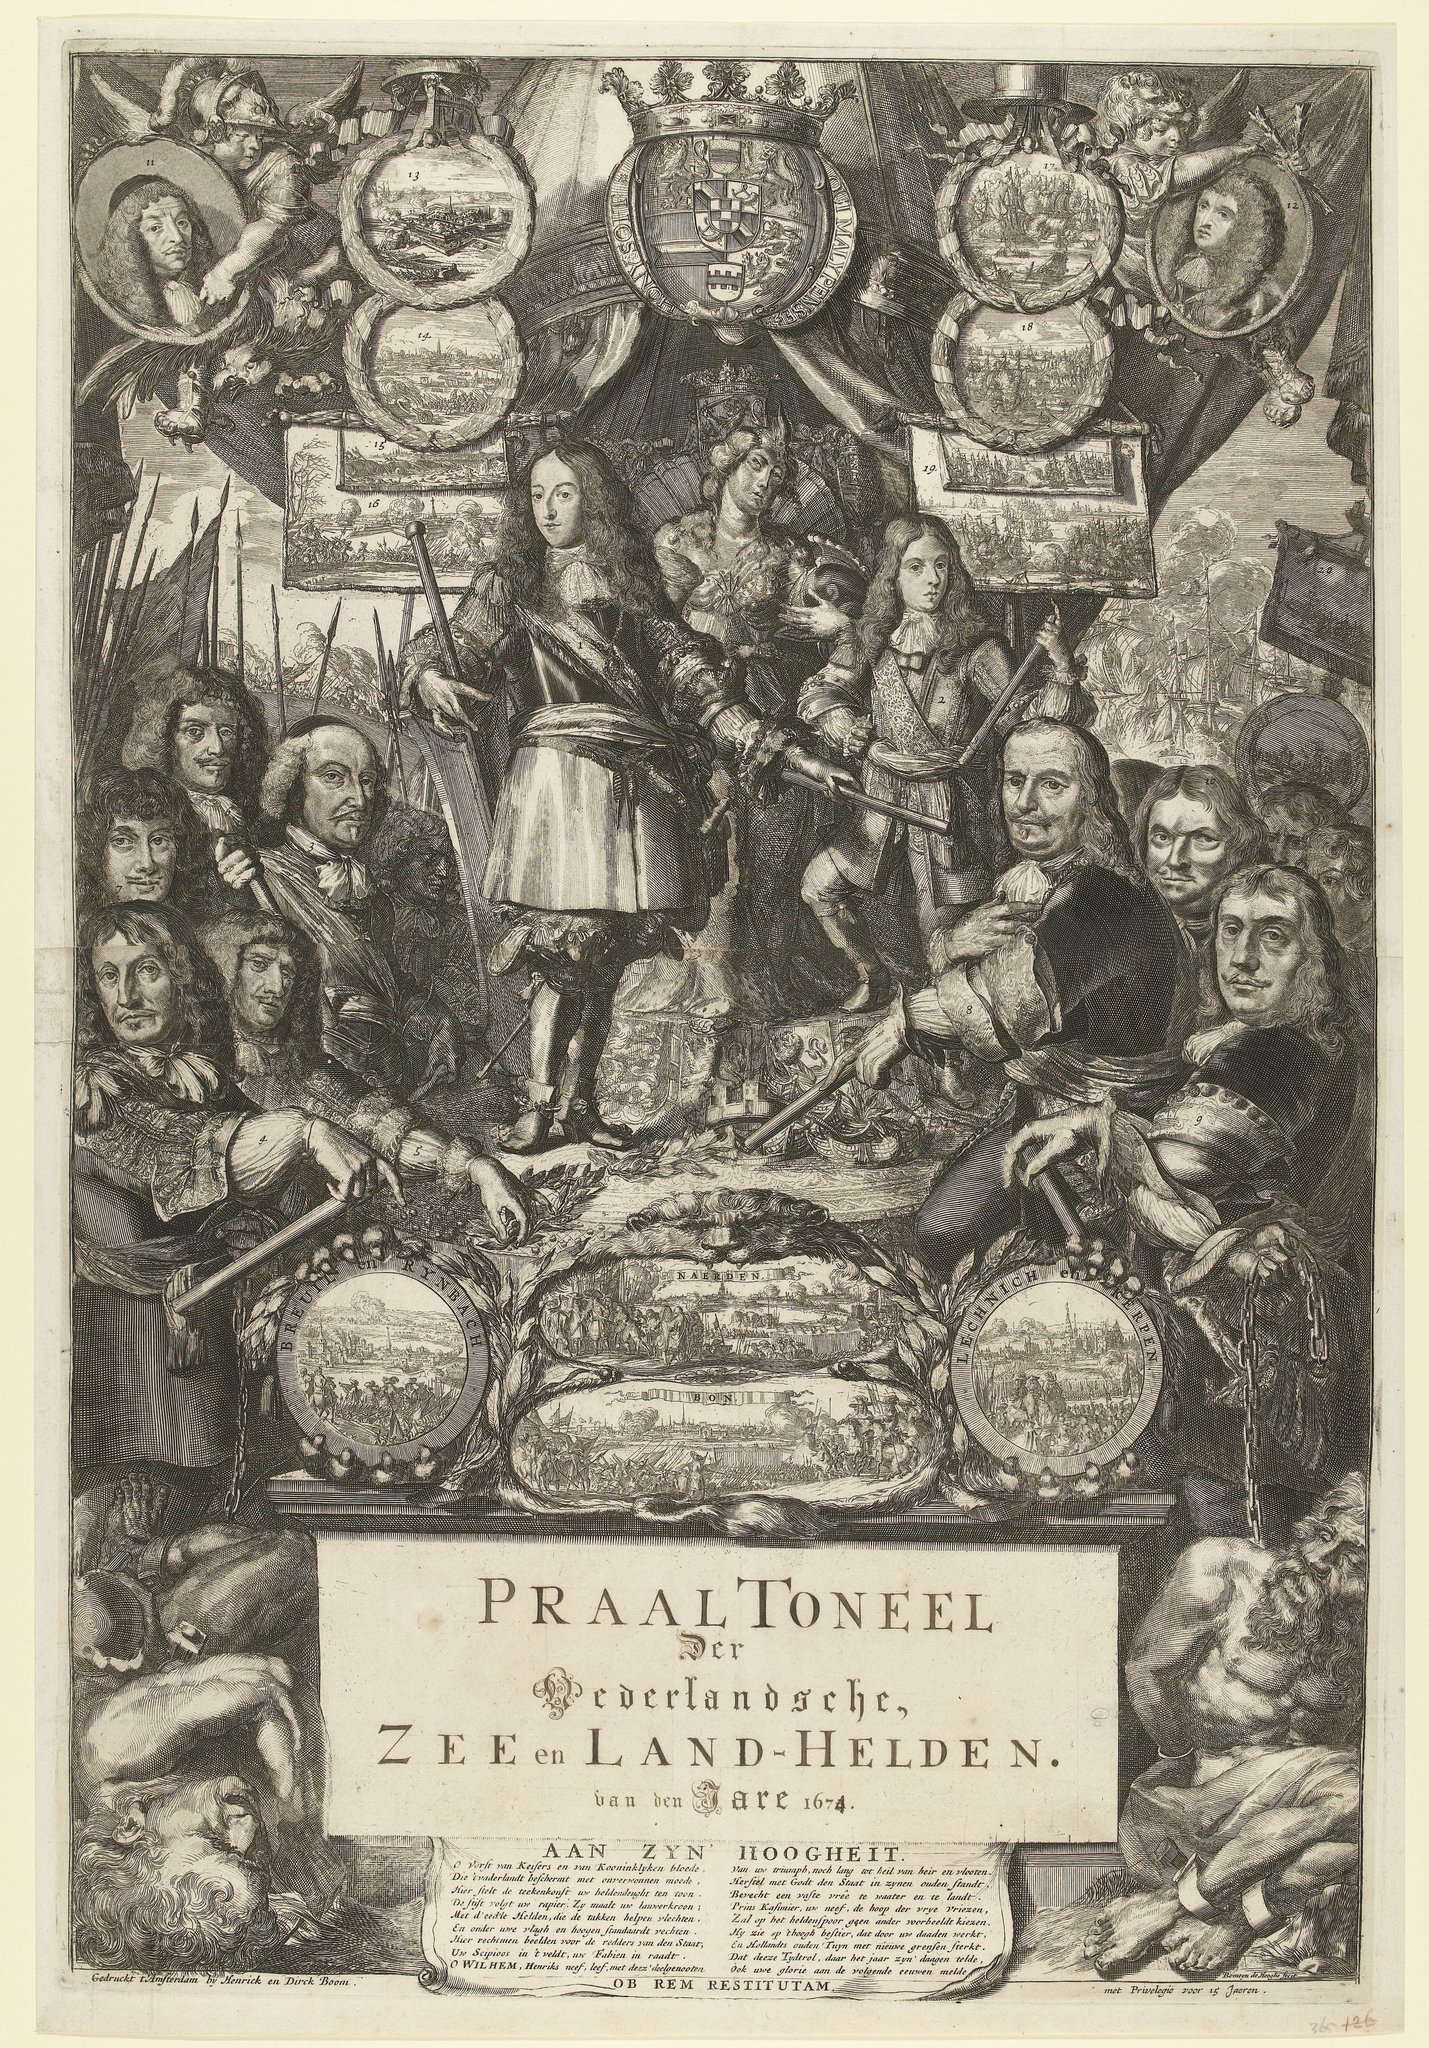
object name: propagandaprent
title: Allegorie op de overwinningen van Willem III in 1673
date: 1673-1674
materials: ink, paper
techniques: engraving, etching, pen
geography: northern netherlands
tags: flushing, michiel adriaenszoon de ruyter, rotterdam, amsterdam, cornelis tromp, johan maurits graaf van nassau-siegen, the hague, william iii (prince of orange and king of england, scotland, and ireland), juan domingo méndez de haro y fernández de córdoba, hendrik casimir ii graaf van nassau-dietz, commander-in-chief, general, marshal, prince, military glory, commander-in-chief, admiral, rampjaar (disaster year)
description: Allegorie op de overwinningen van Willem III in 1673. De jonge prins met commandostaf staande naast de jonge Hendrik Casimir. Hiervoor bevelhebbers die in 1673 overwinningen behaalden: Michiel Adriaenszoon de Ruyter, Cornelis Tromp, Adriaen Banckert, Johan Maurits, Paulus Wirtz, George Frederik van Waldeck, Rabenhaupt en graaf Willem van Hornes. Hieromheen medaillons en cartouches met overwinningen. Bovenaan links het portret van Montecuccoli en rechts Monterrey. Onderaan een open ruimte bestemd voor de almanak voor het jaar 1674 met in handschrift de titel. Aan weerszijden geketende gevangenen. In de plaat onderaan een vers in twee kolommen in het Nederlands gericht aan de vorst.